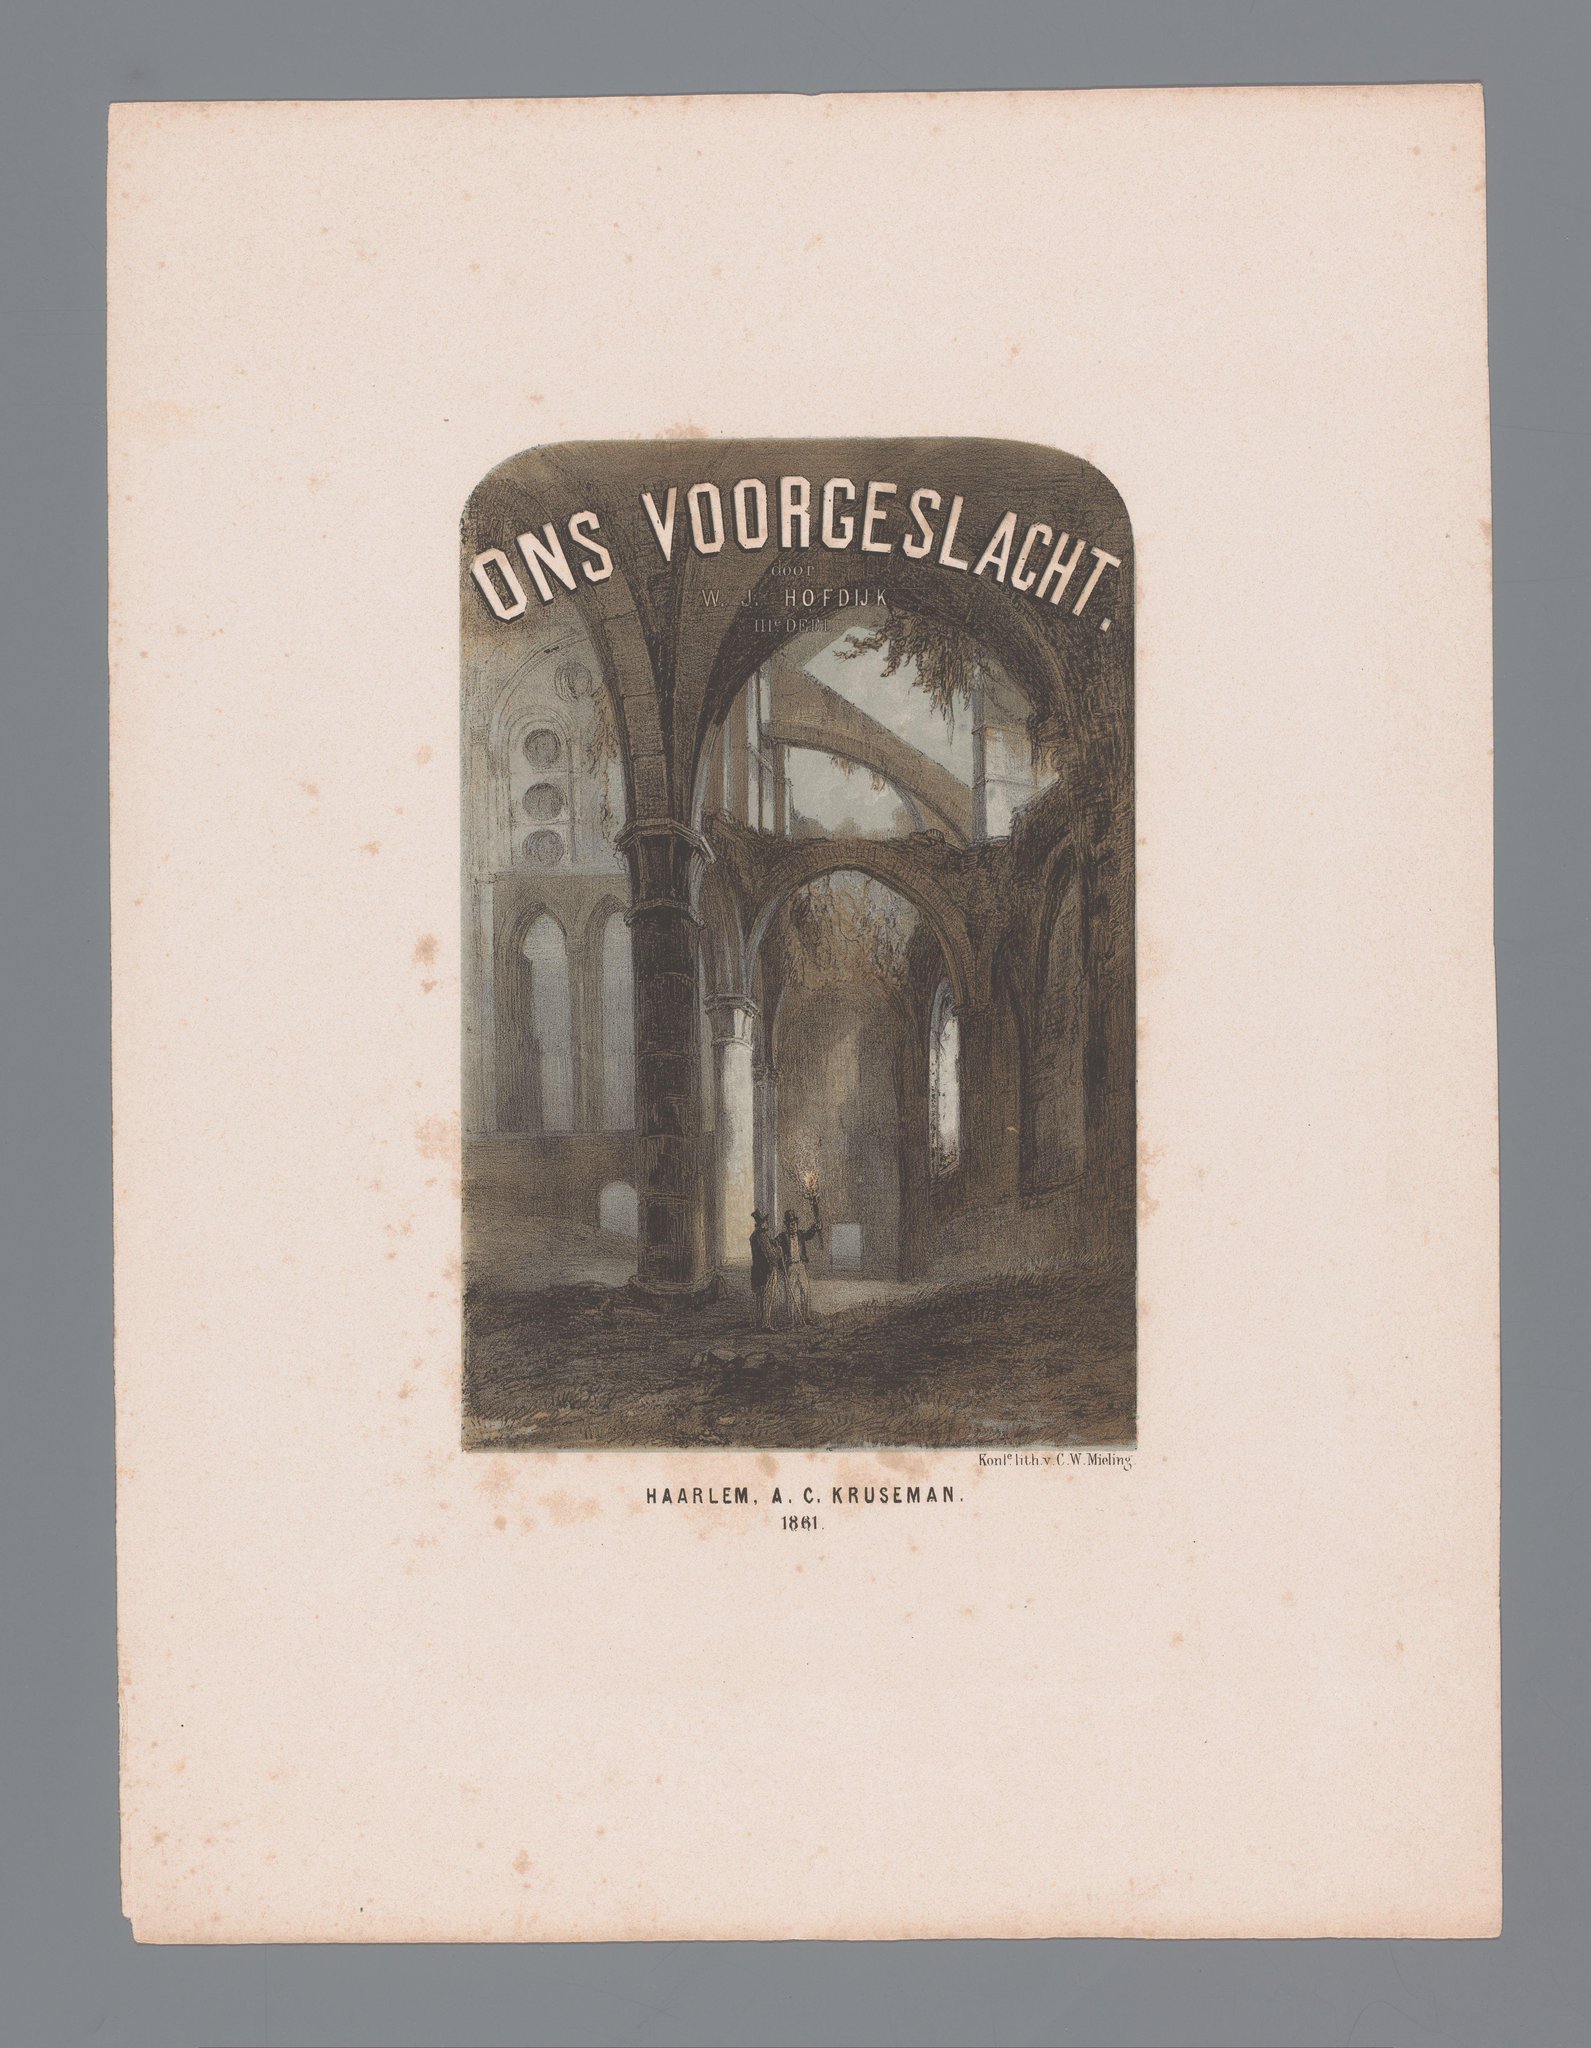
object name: print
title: Twee mannen in een ruïne van een kerk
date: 1861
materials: paper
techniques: tone lithography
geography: the hague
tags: ruin of church, monastery, etc.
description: Een van de twee mannen houdt een brandende fakkel omhoog.